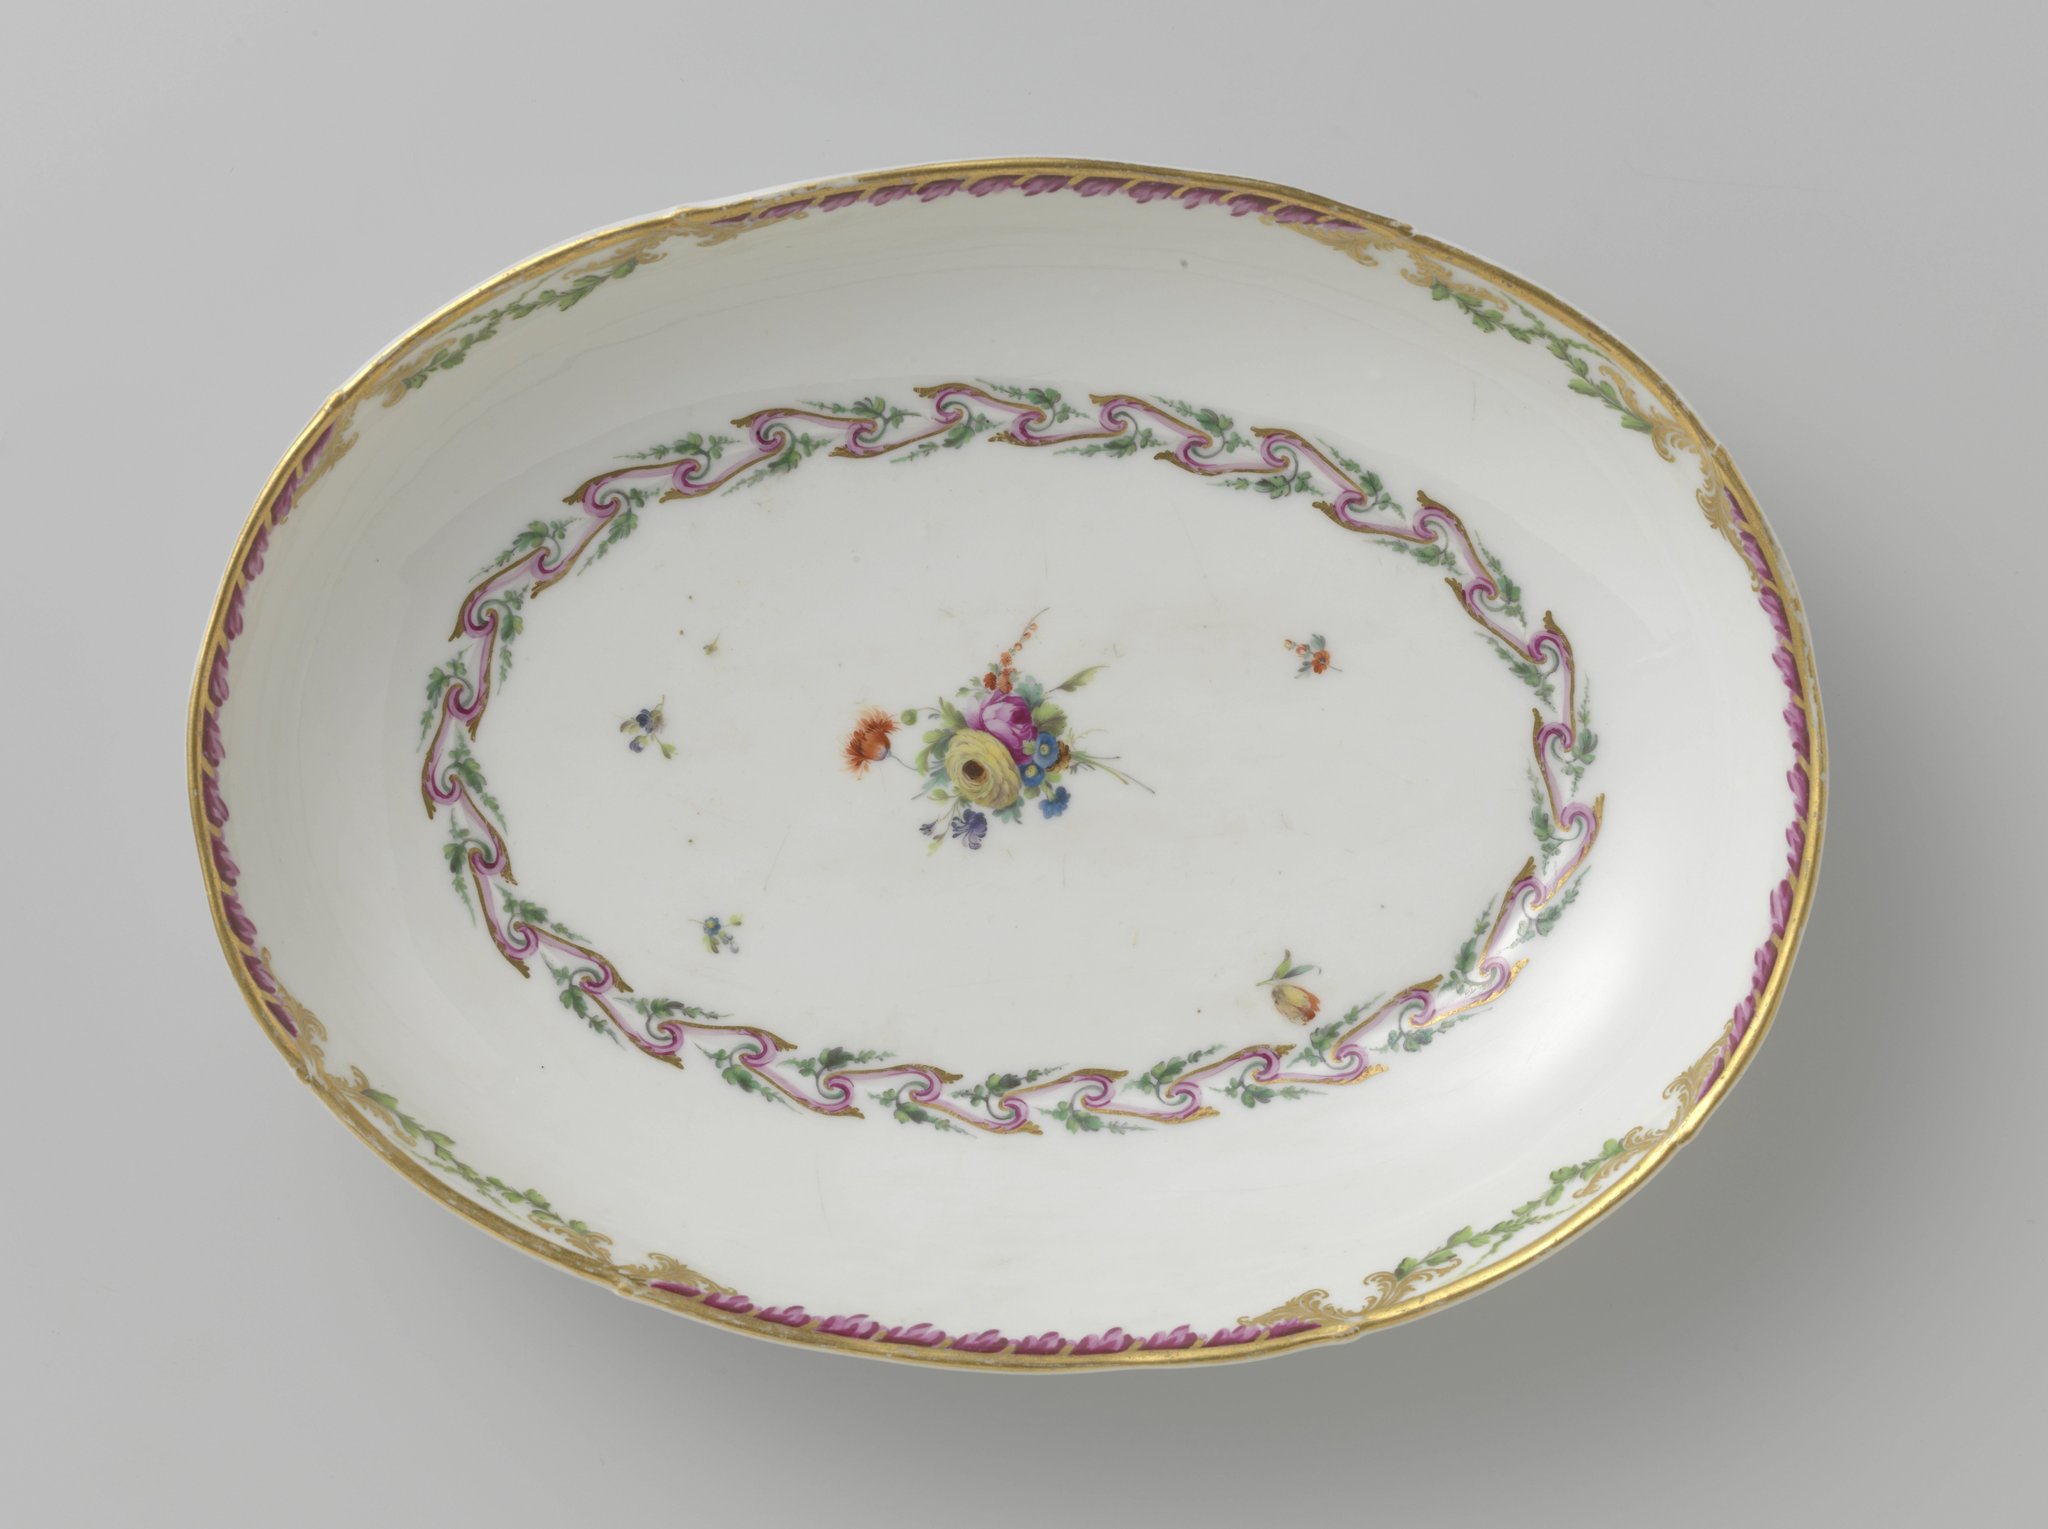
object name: dish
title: Schaal, diep en ovaal van vorm,behorend bij een servies met geslingerd lintmotief met bladertakken, bloemboeketten en gestrooide bloemtakken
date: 1780-1820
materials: porcelain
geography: amsterdam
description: Schaal, diep en ovaal van vorm, behorend bij een servies van porselein, versierd met een geslingerd lintmotief in paars en goud met groene bladertakken, bloemboeketten en gestrooide bloemtakken. Randen lichtgegolfd met decoratie in goud met paars bladmotief waartussen groen gekruist bladmotief. Gemerkt: M.O.L. en Amstel.